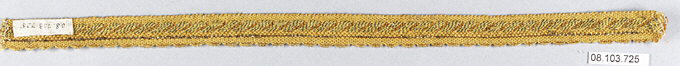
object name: galloon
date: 1801-1900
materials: cotton